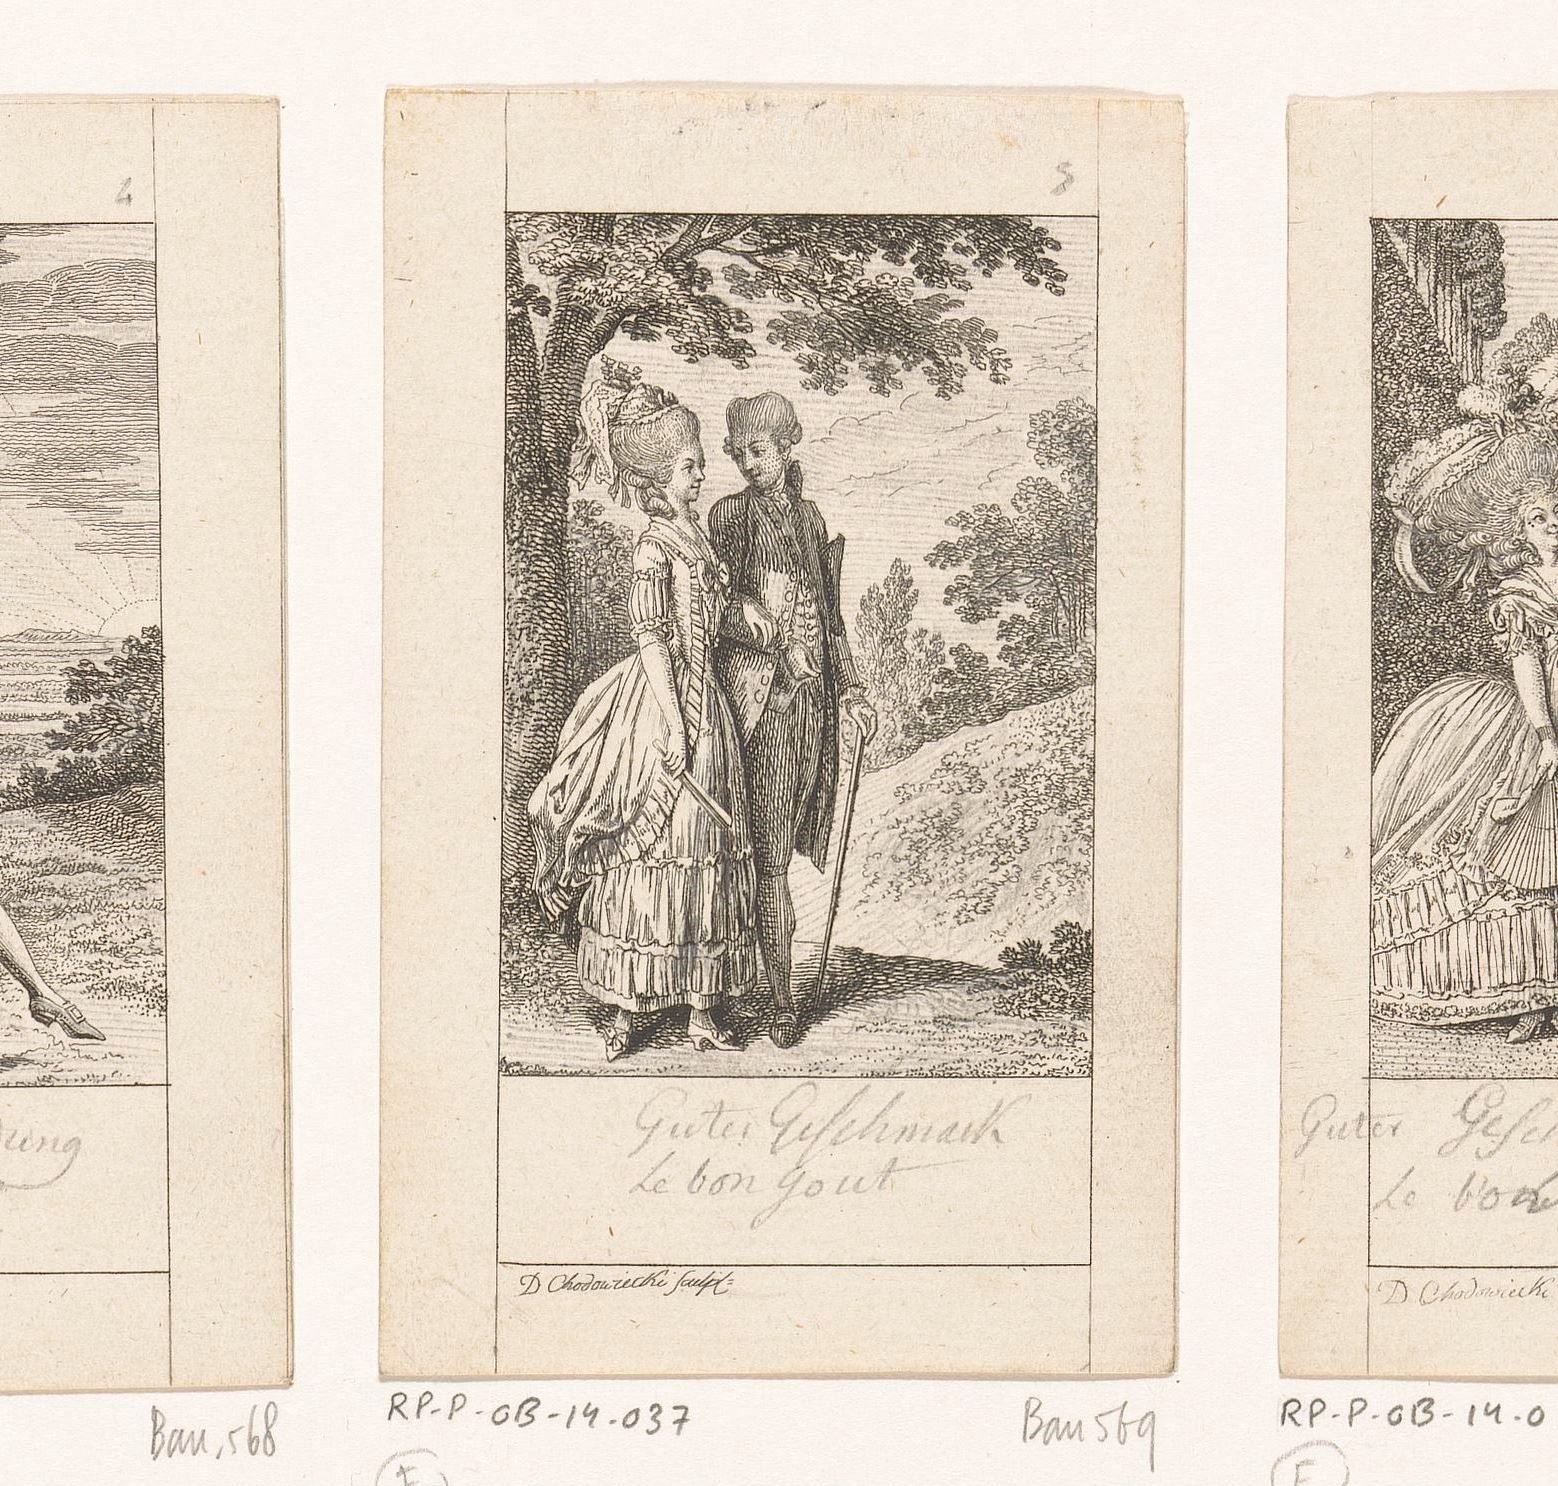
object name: print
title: Goede kledingsmaak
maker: daniel nikolaus chodowiecki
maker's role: draughtsman, print maker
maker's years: 1726-1801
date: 1779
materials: paper, pencil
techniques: etching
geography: berlin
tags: fashion, clothing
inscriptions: collector's mark: Lugt 2228, inscription: ‘Gute Geschmack / Le bon gout’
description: Vijfde prent uit een serie van twaalf taferelen die 'Natürliche und affectirte Handlungen des Lebens' (tweede serie) illustreren waarin 'natuurlijk' en 'geaffecteerd' gedrag op karikaturale wijze tegenover elkaar worden gezet. Deze taferelen zijn op een plaat geëtst. Een latere staat van deze serie, voorzien van toelichtingen door Georg Christoph Lichtenberg, is ook gebruikt in: Almanac de Goettingue pour l'année 1780. Göttingen: Johann Christian Dieterich.